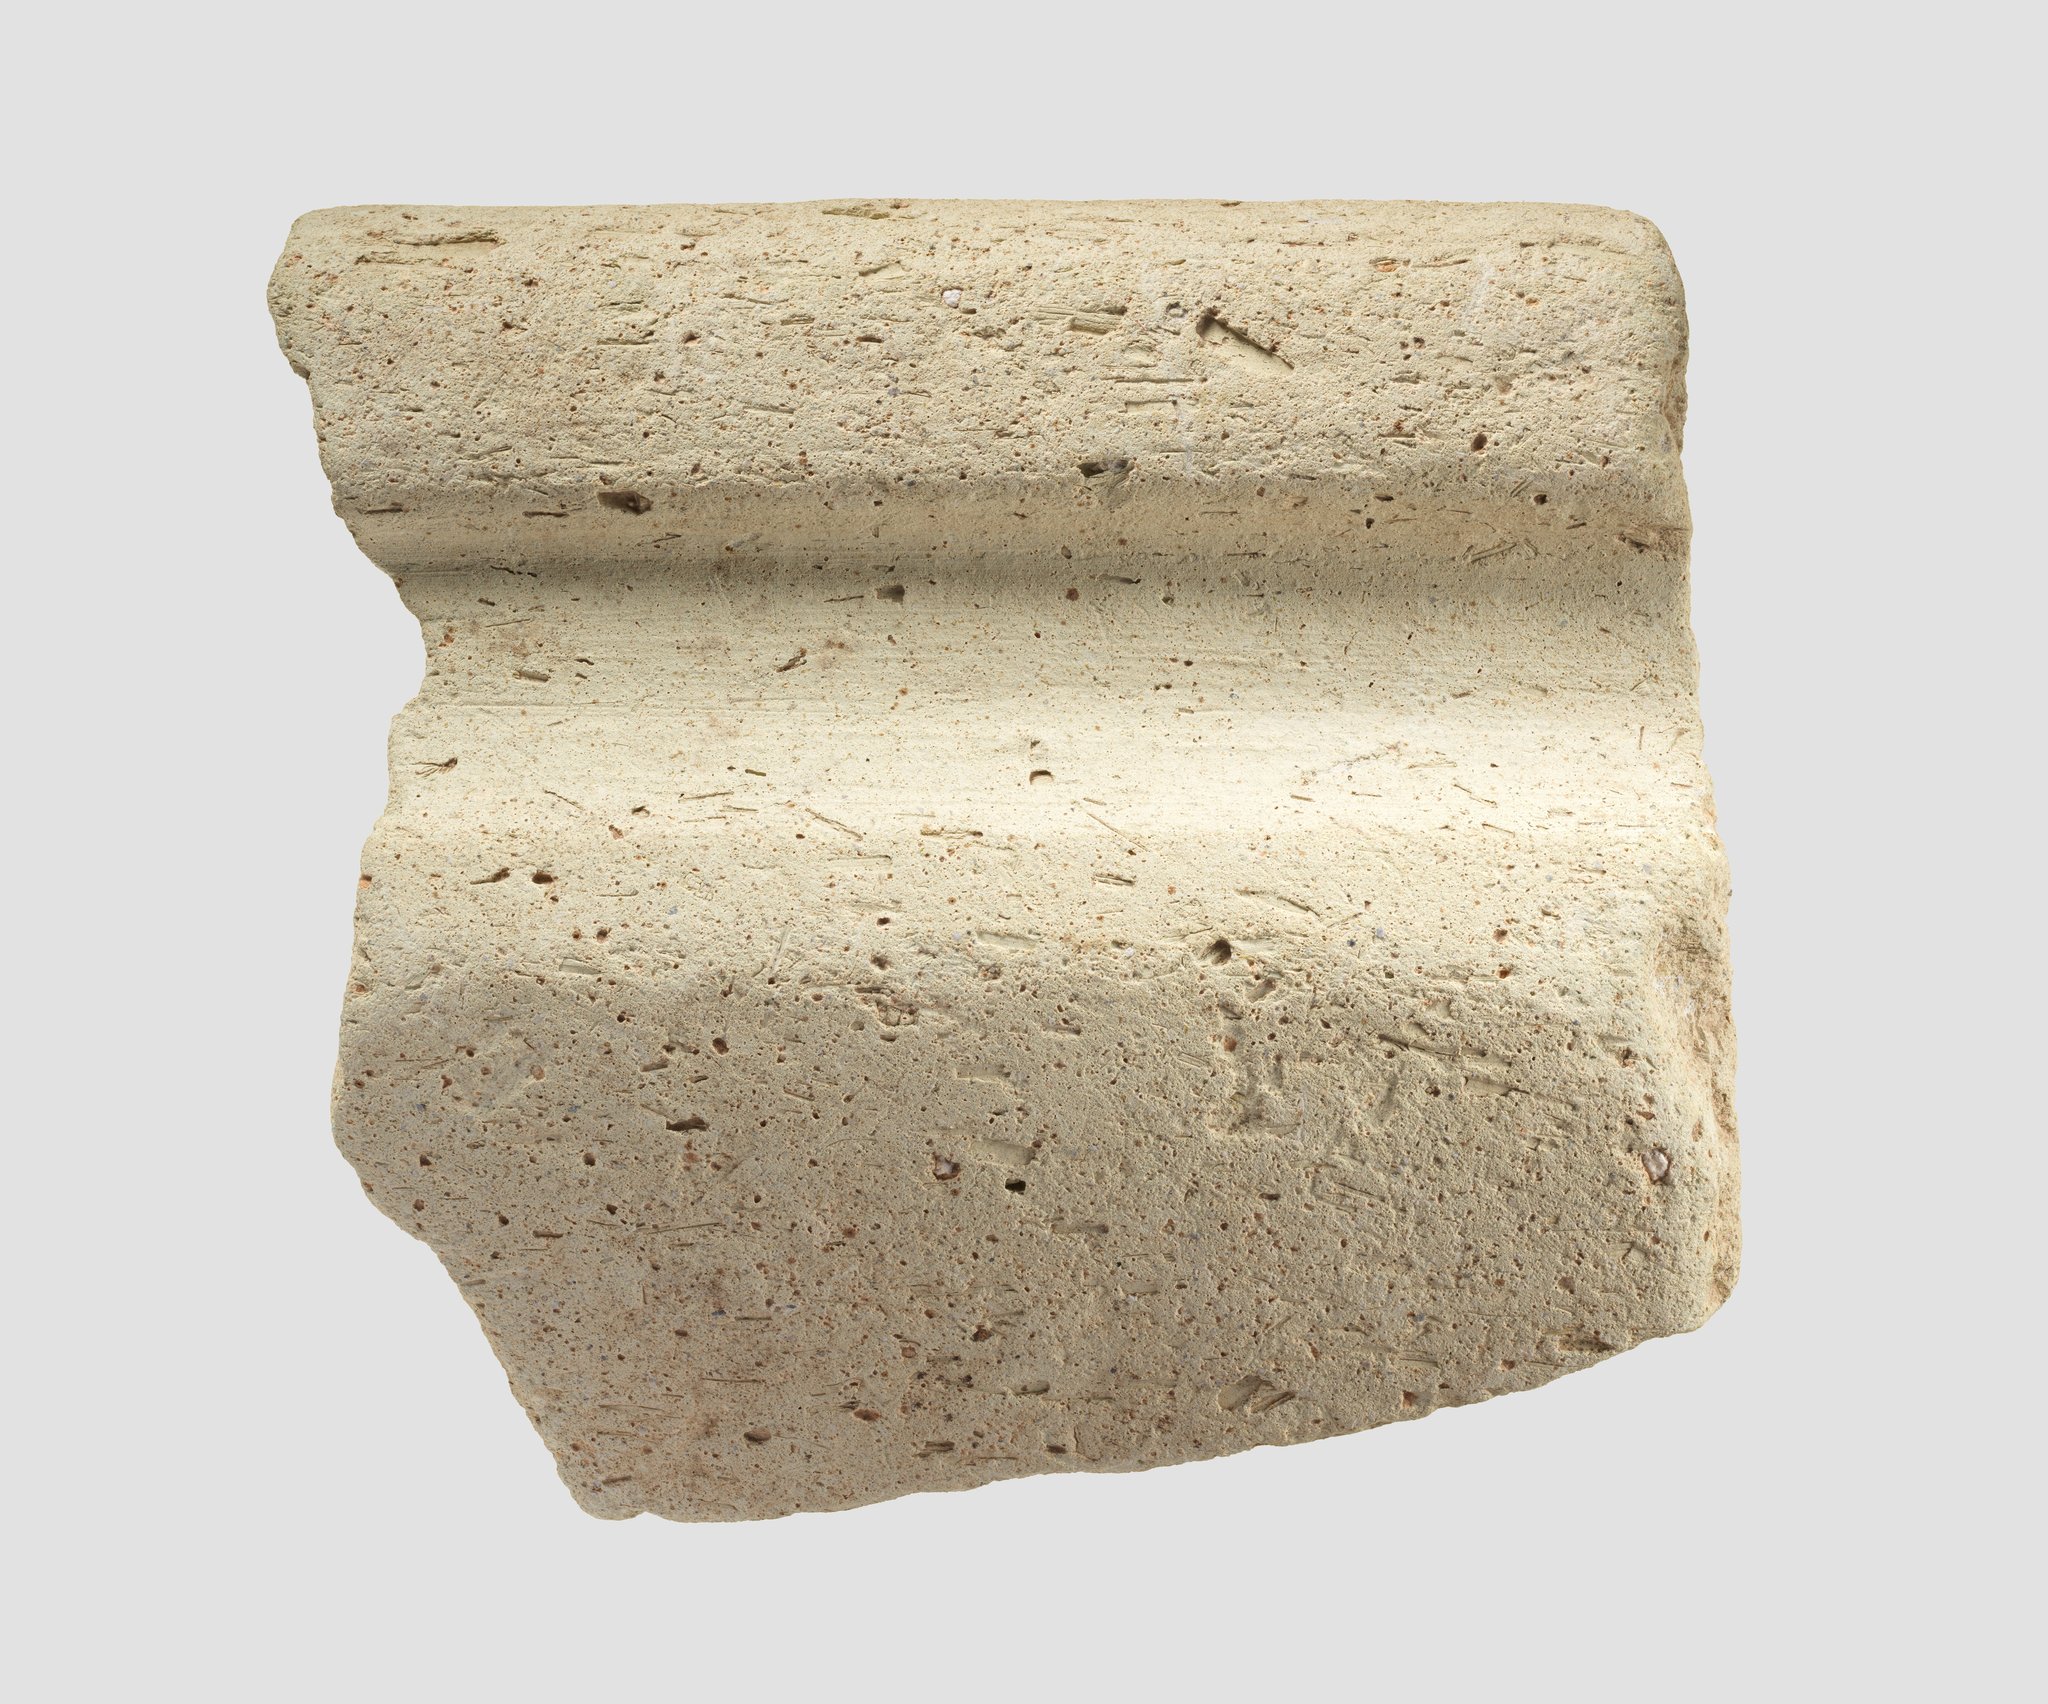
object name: sherd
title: Rim sherd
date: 2333-2001 BCE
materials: ceramic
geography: mesopotamia